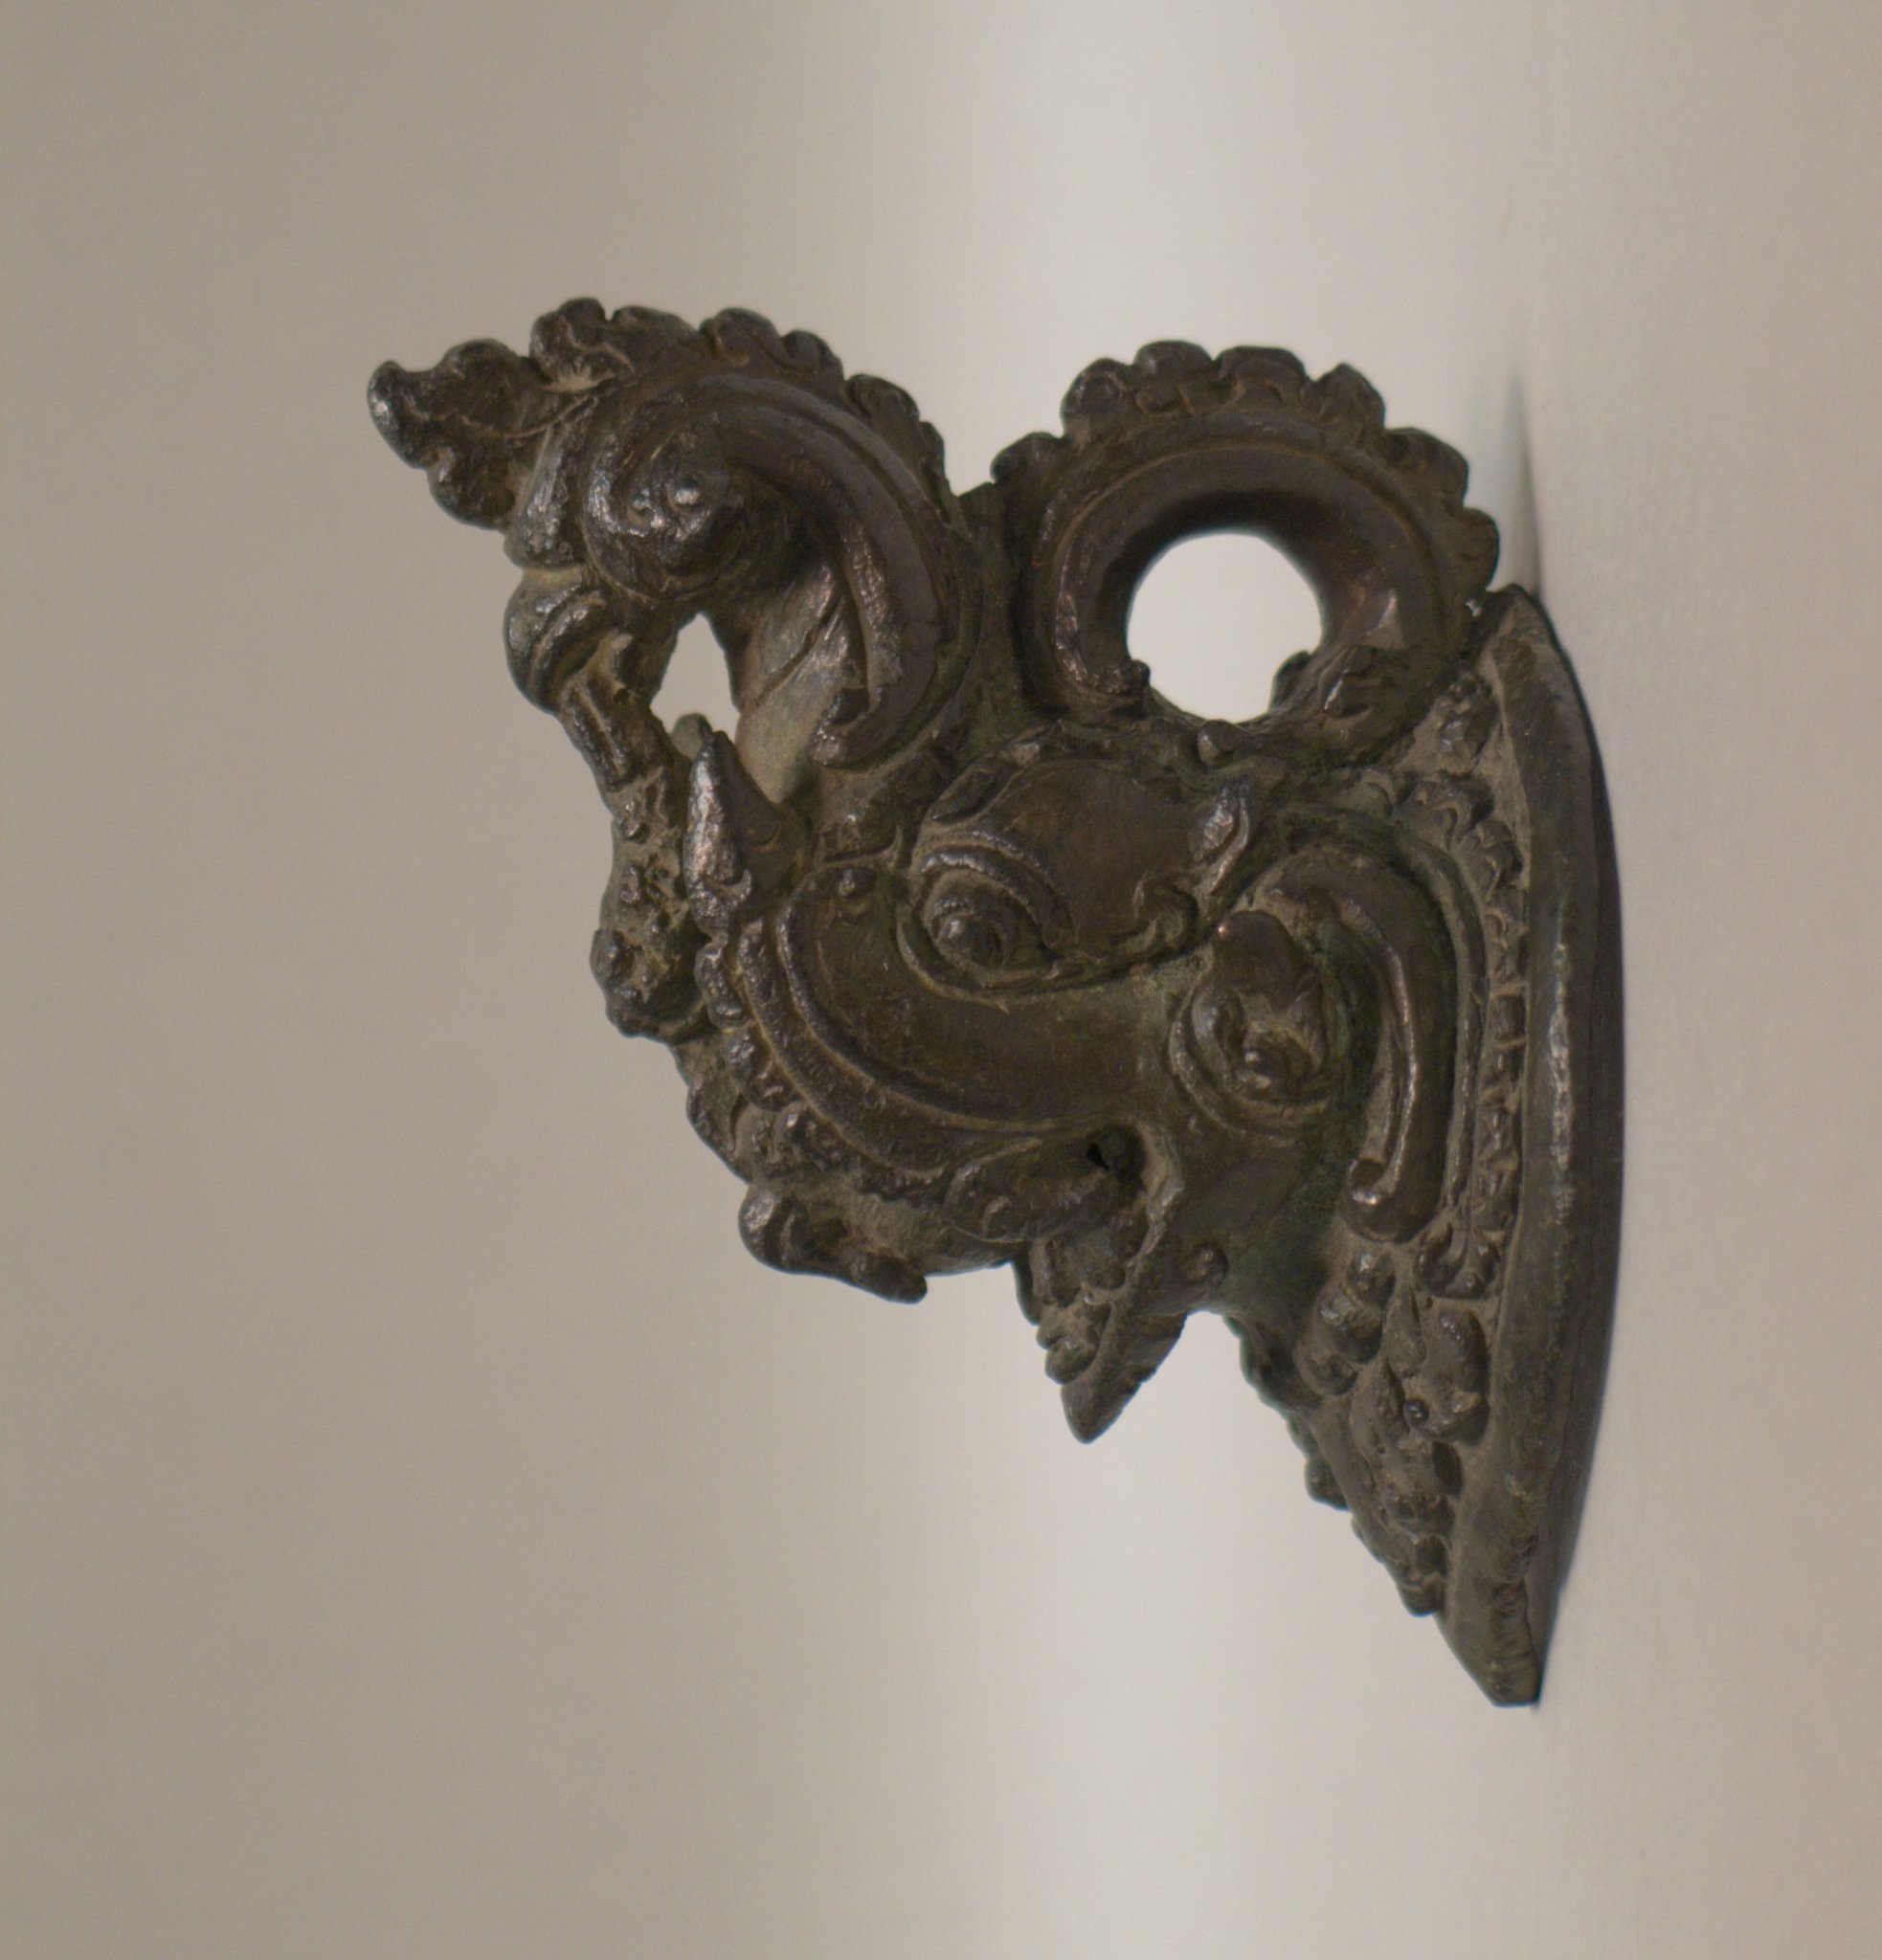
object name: ewer handle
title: Makara-Shaped Handle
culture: indonesian, javanese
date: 901-1100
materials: bronze